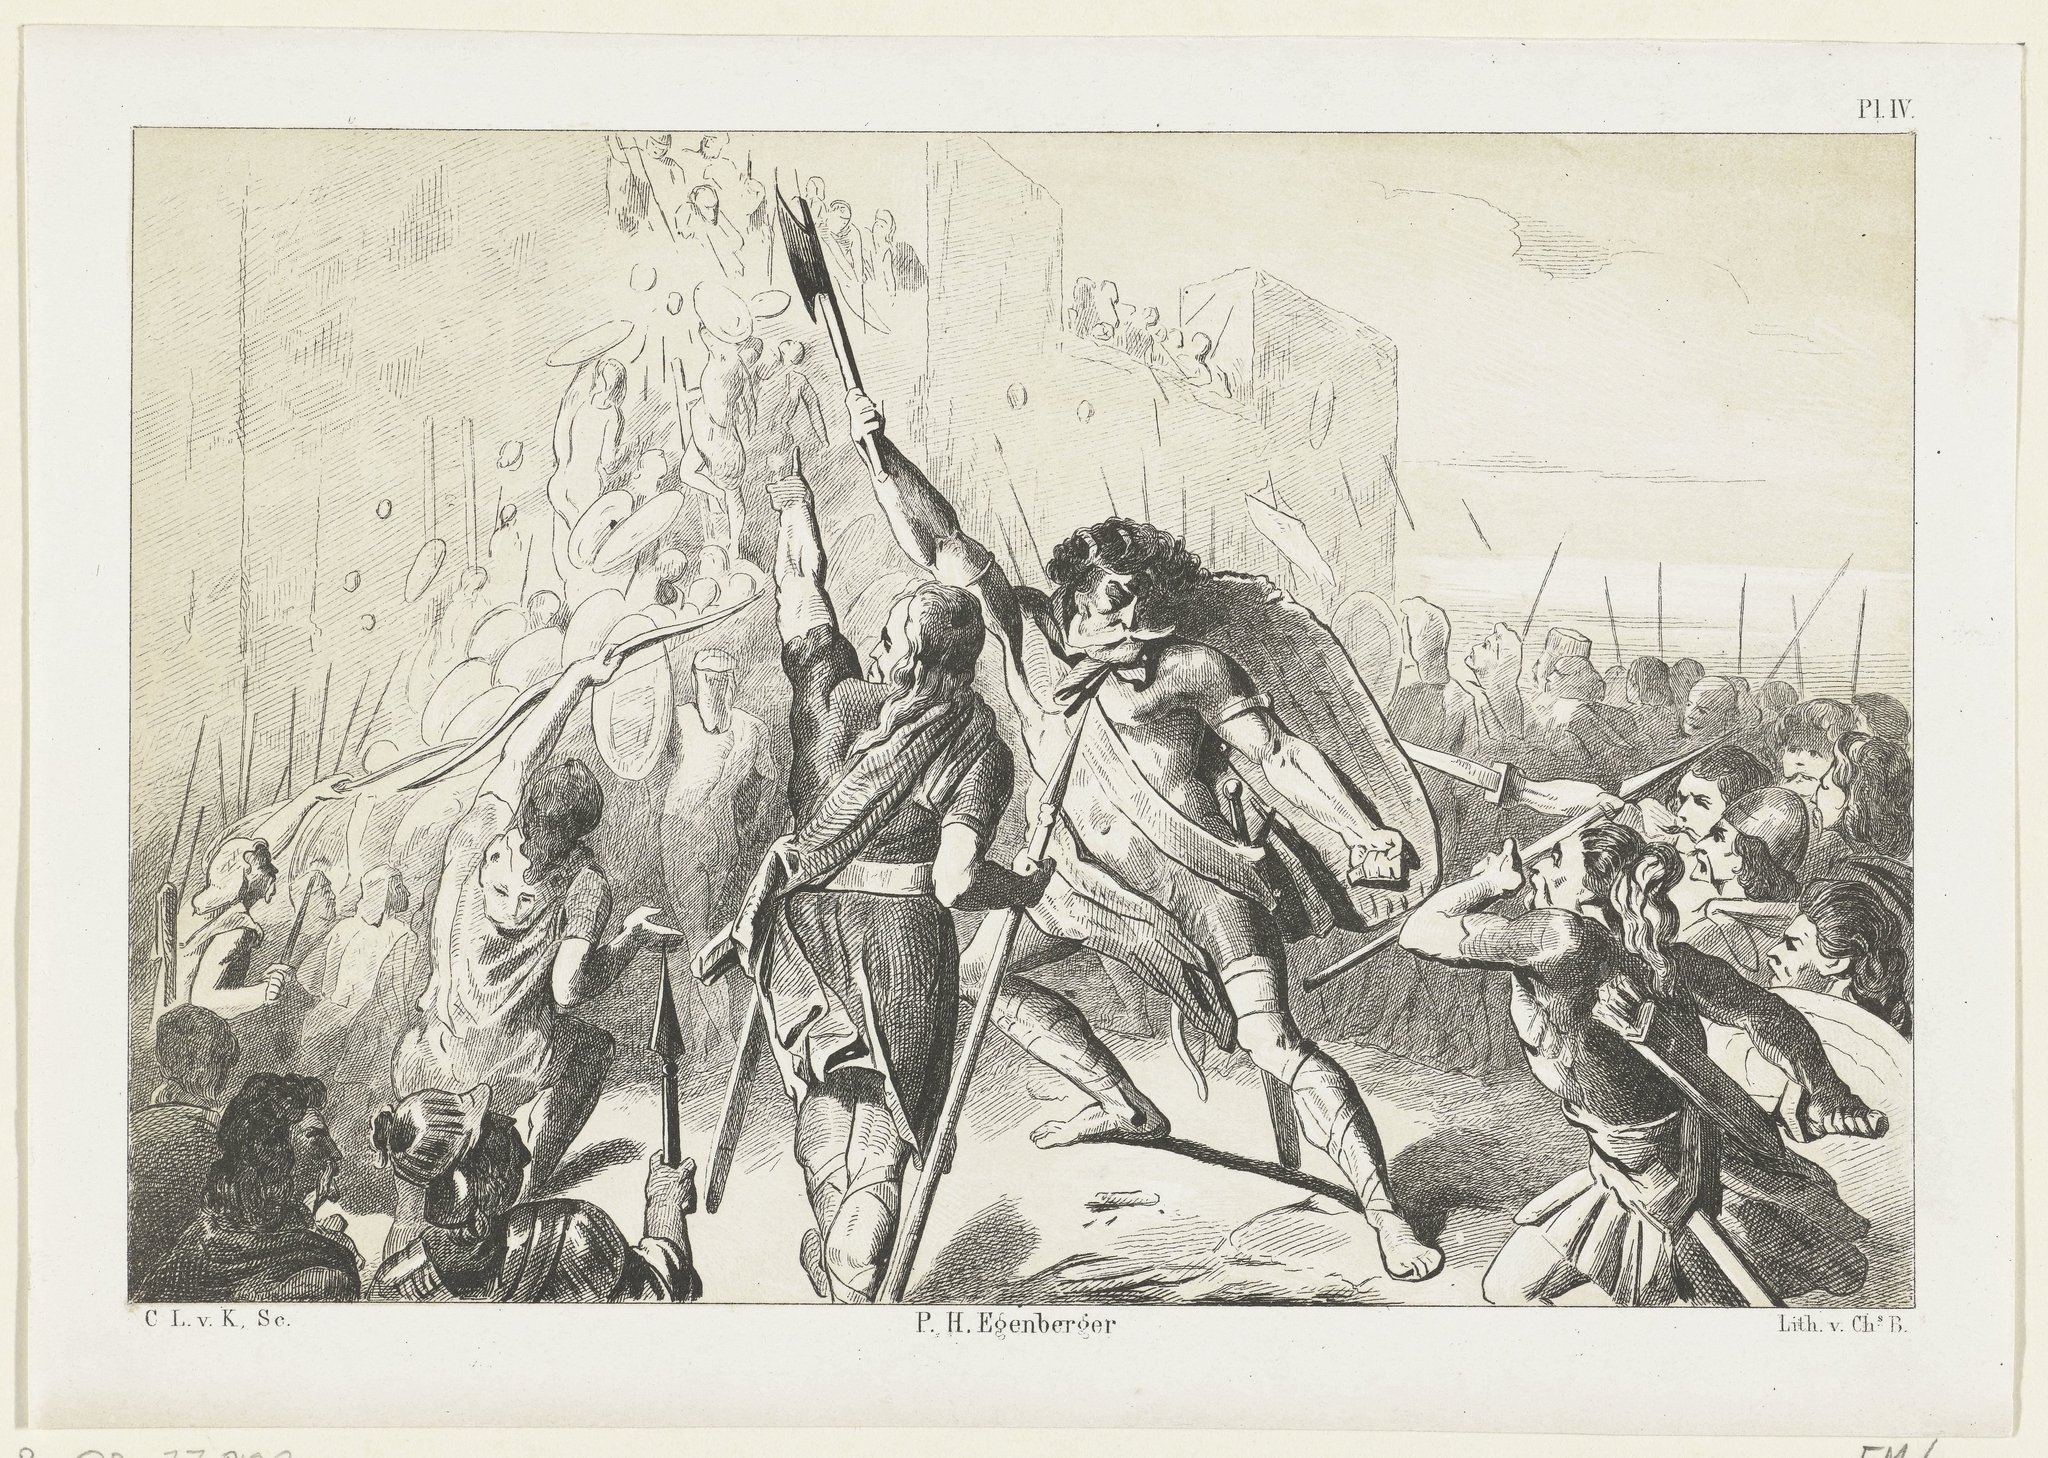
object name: history print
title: Troepen van Civilis bestormen de Romeinse vesting Castra Vetera te Xanten, 69-70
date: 1853-1861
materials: paper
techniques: lithograph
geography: netherlands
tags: siege, position war, extinct, 'historical' peoples (with name)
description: Illustratie voor: Jacob van Lennep, De geschiedenis des vaderlands in schetsen en afbeeldingen, Binger, Amsterdam 1855-1861, 8 delen, pl. IV.